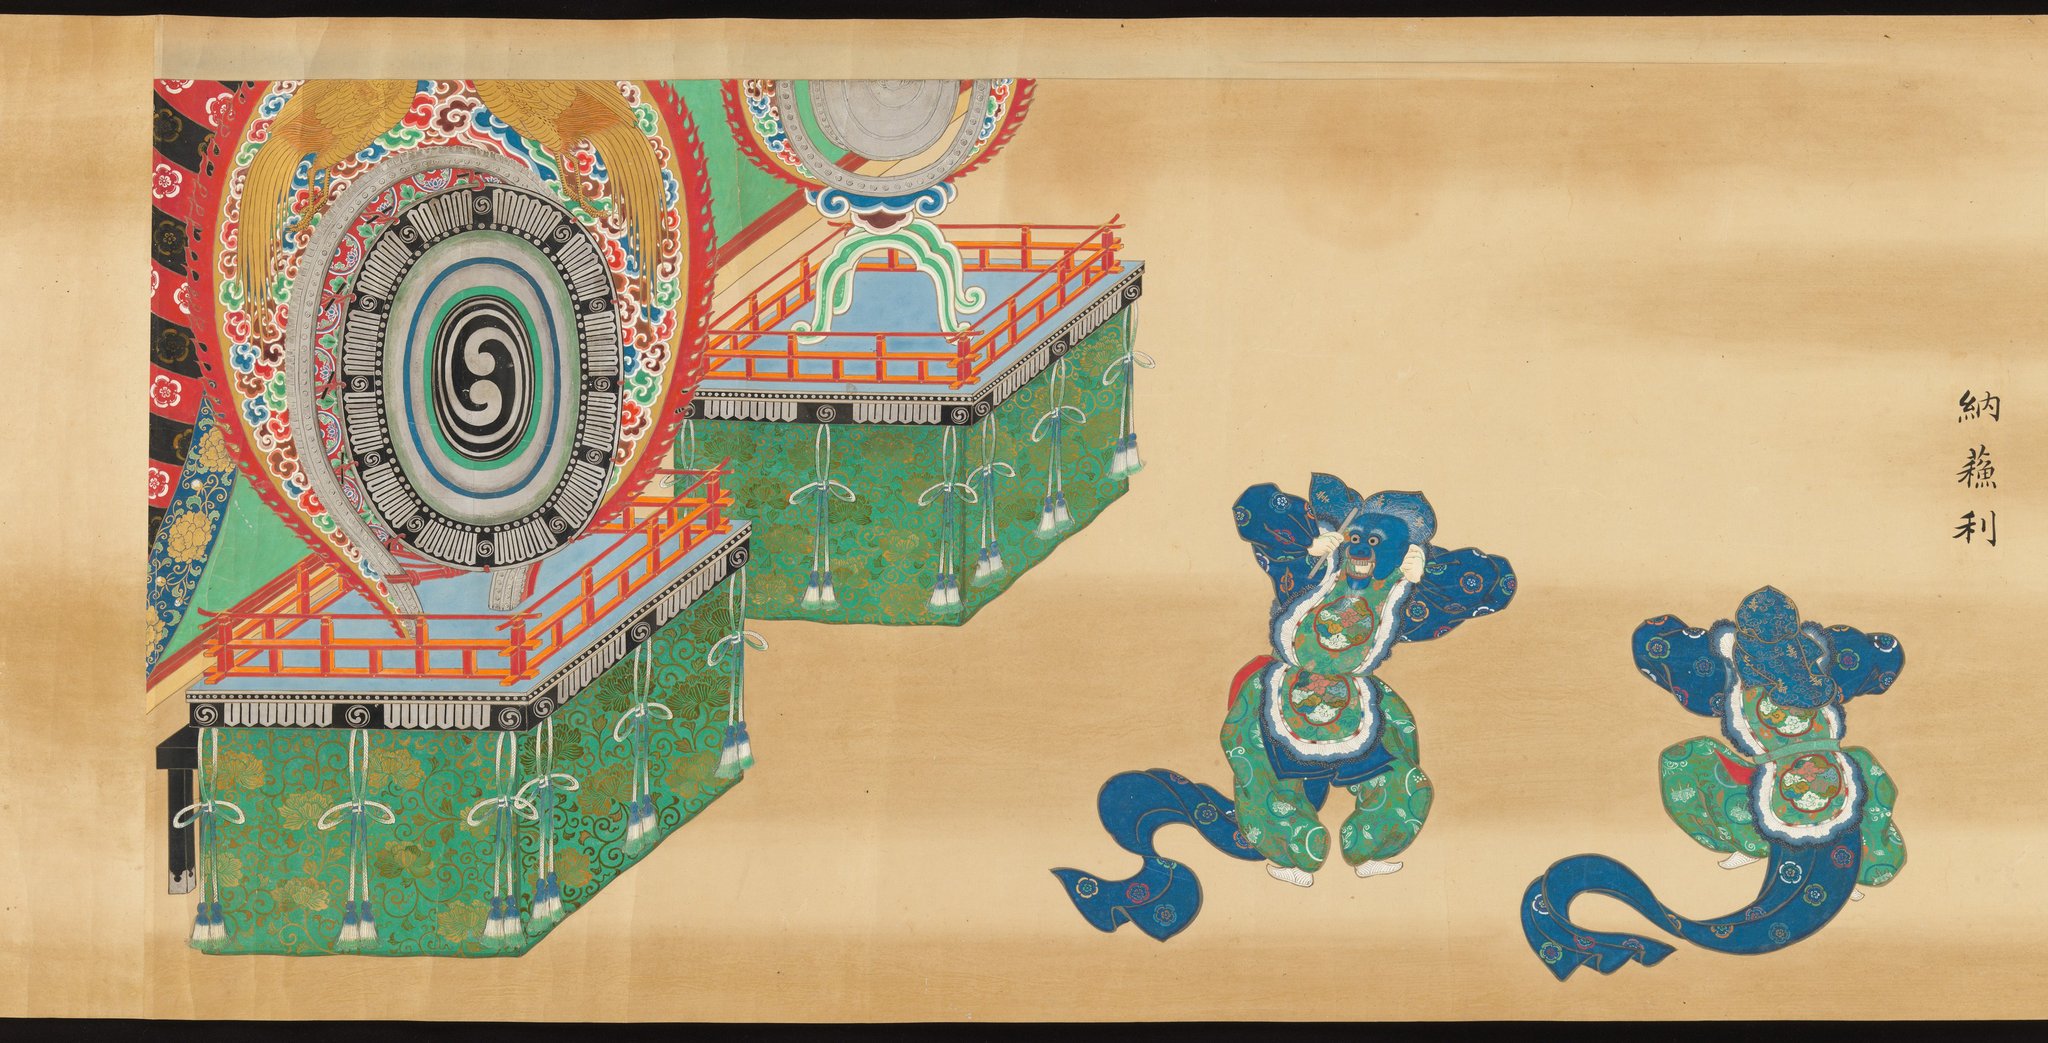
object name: handscroll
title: Bugaku Scroll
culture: japanese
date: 1601-1700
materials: gold, ink, paper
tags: men,dancing,dancers